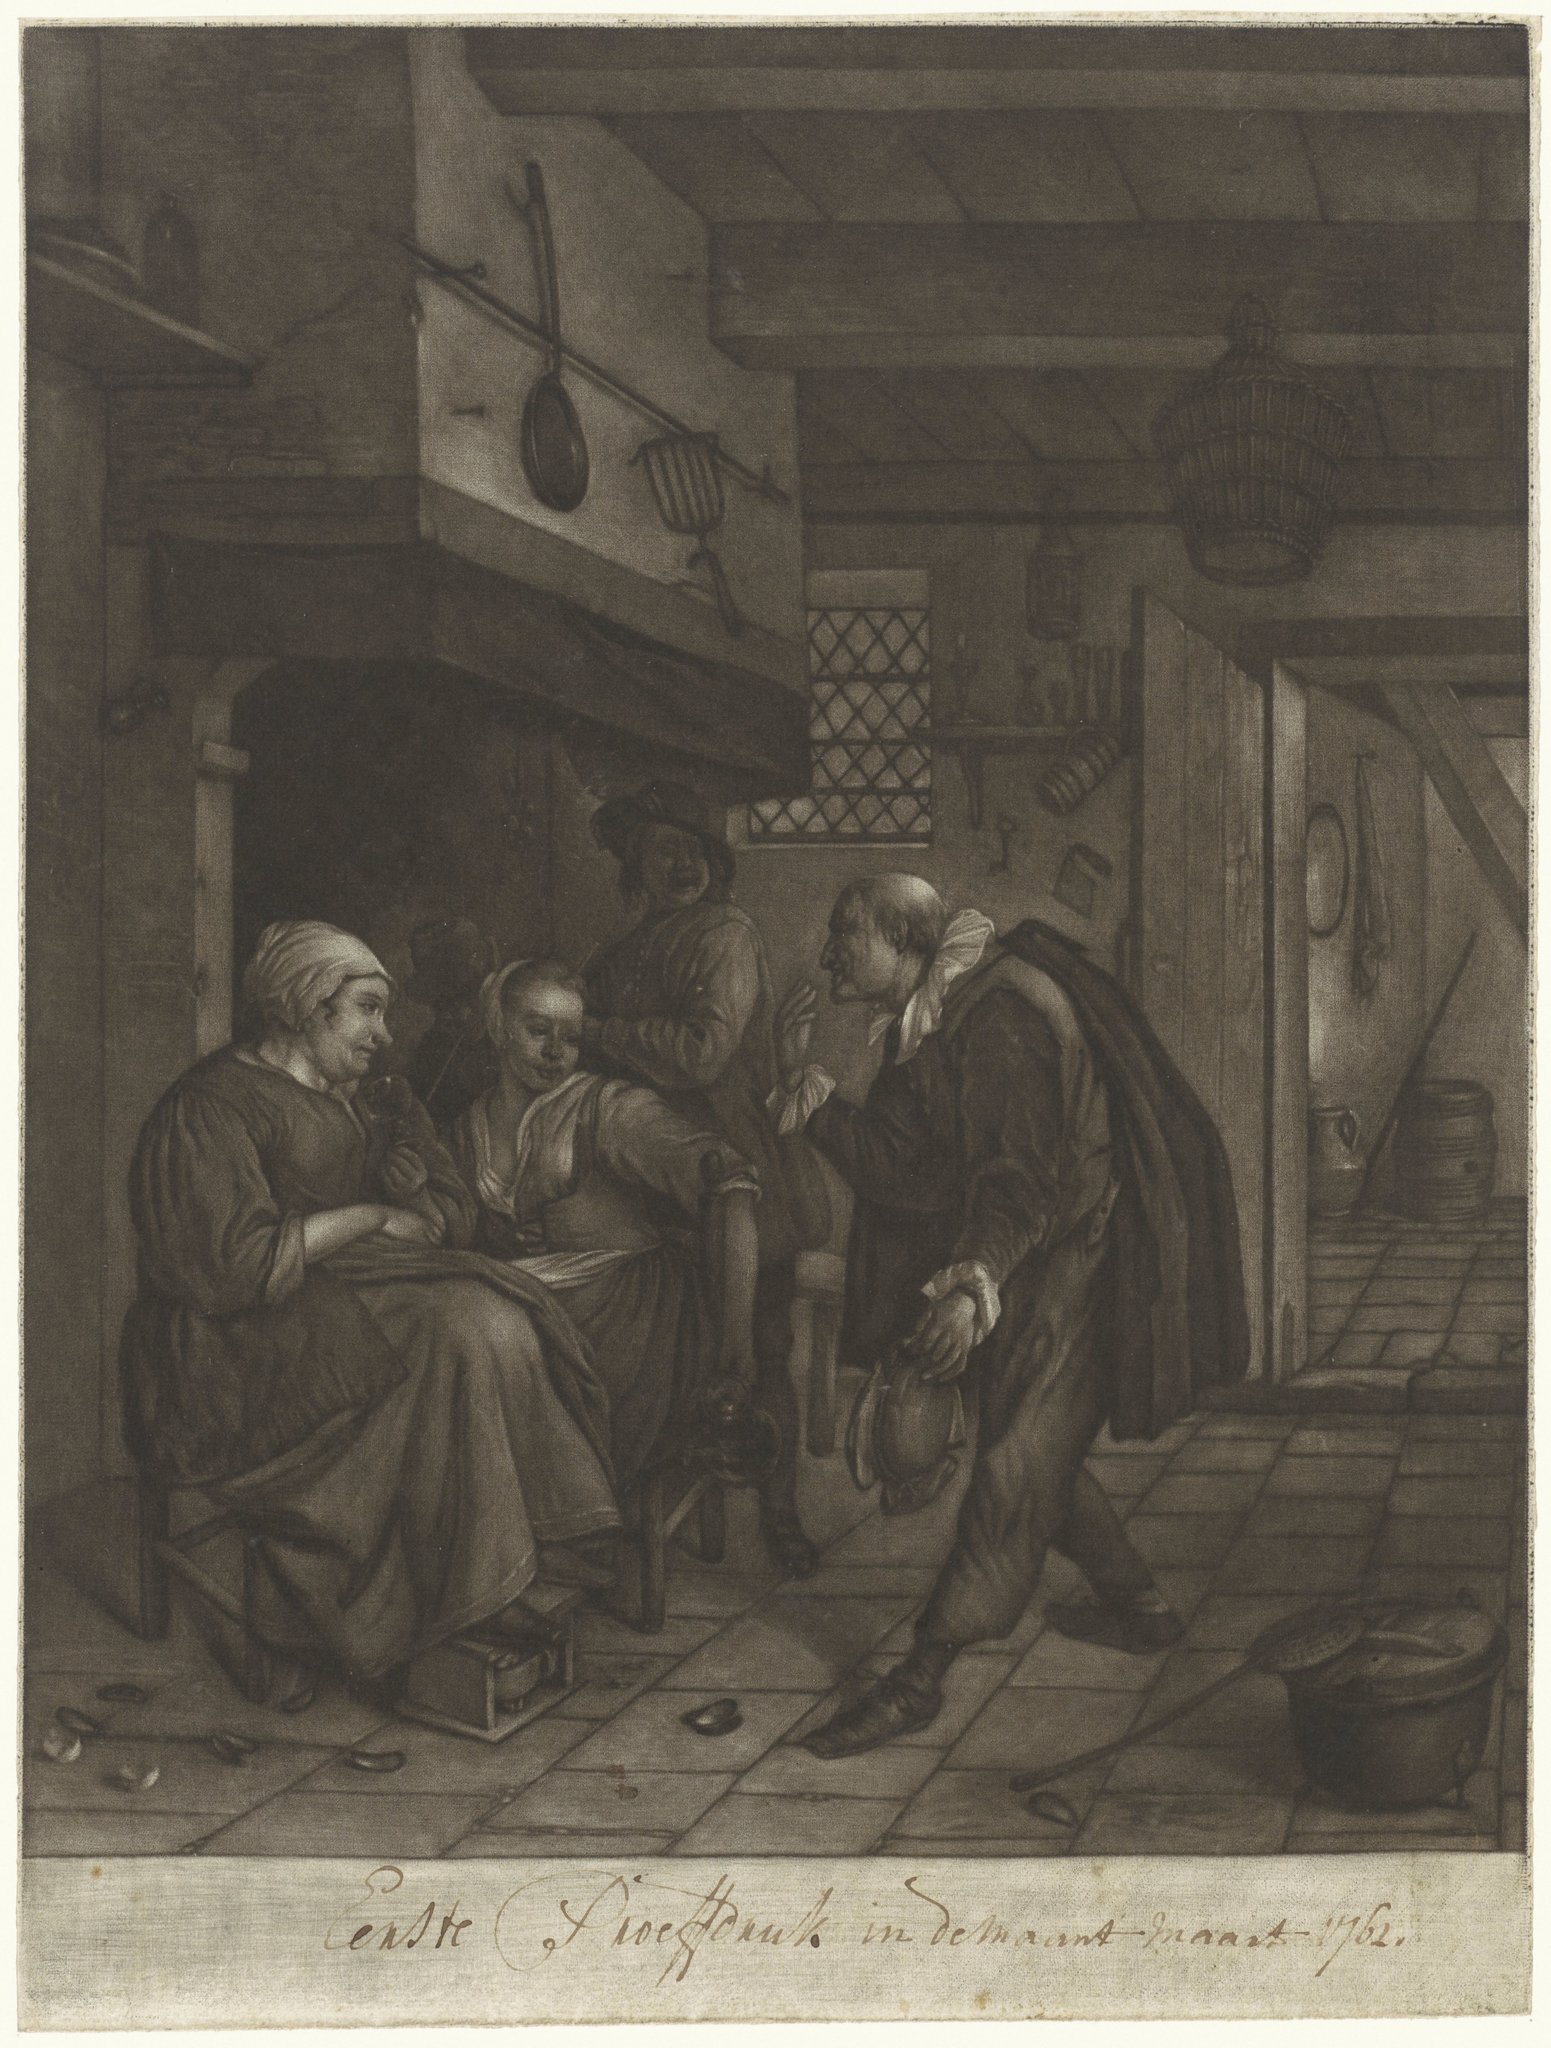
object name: print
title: Herbergscène met twee vrouwen die mossels hebben gegeten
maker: jan stolker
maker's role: draughtsman, painter, print maker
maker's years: 1724-1785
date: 1762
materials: paper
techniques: mezzotint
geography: northern netherlands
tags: chimney, foot-stove, inn, coffee-house, public house, etc., pipe ~ tobacco, molluscs: mussel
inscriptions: collector's mark: Lugt 2228, inscription: ‘Eerste Proeffdruk in de Maant Maart 1762.’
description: In een herberg begroet een oude man twee vrouwen die bij de haard zitten. Op de grond een mosselpan en mosselschelpen. Achter de vrouwen staan twee mannen pijp te roken.